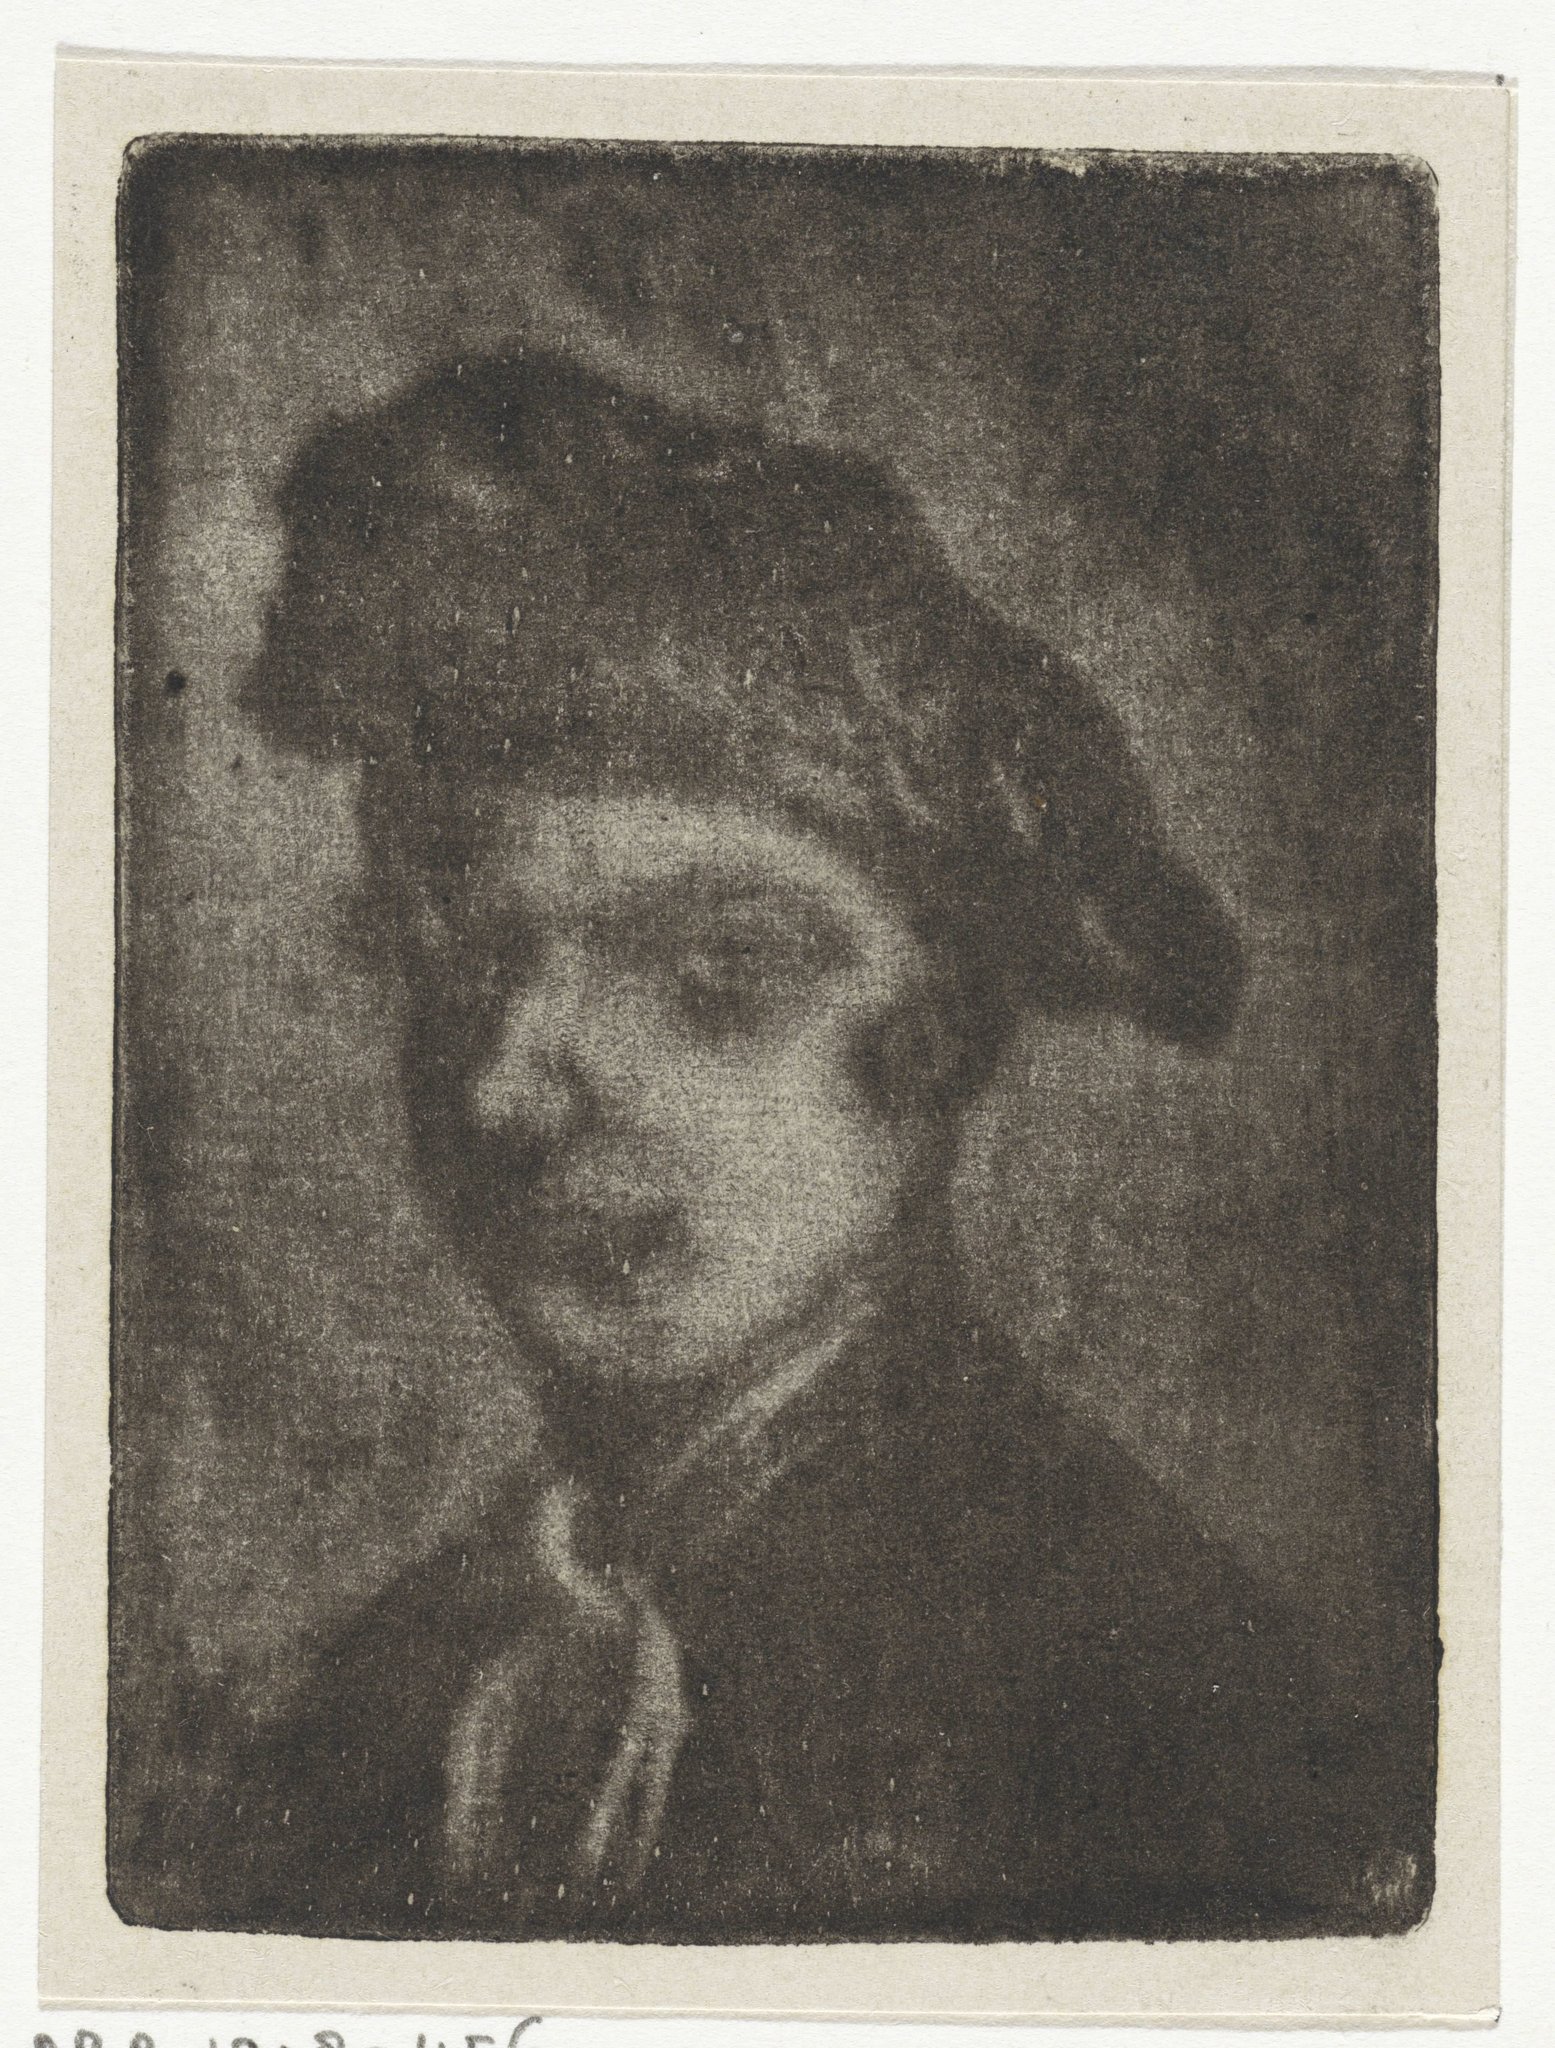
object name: print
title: Jongeman met een pet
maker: eberhard cornelis rahms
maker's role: print maker, publisher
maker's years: 1823-1907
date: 1854-1907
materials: paper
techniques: mezzotint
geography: netherlands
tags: head-gear: cap (+ men's clothes)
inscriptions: collector's mark: Lugt 2228